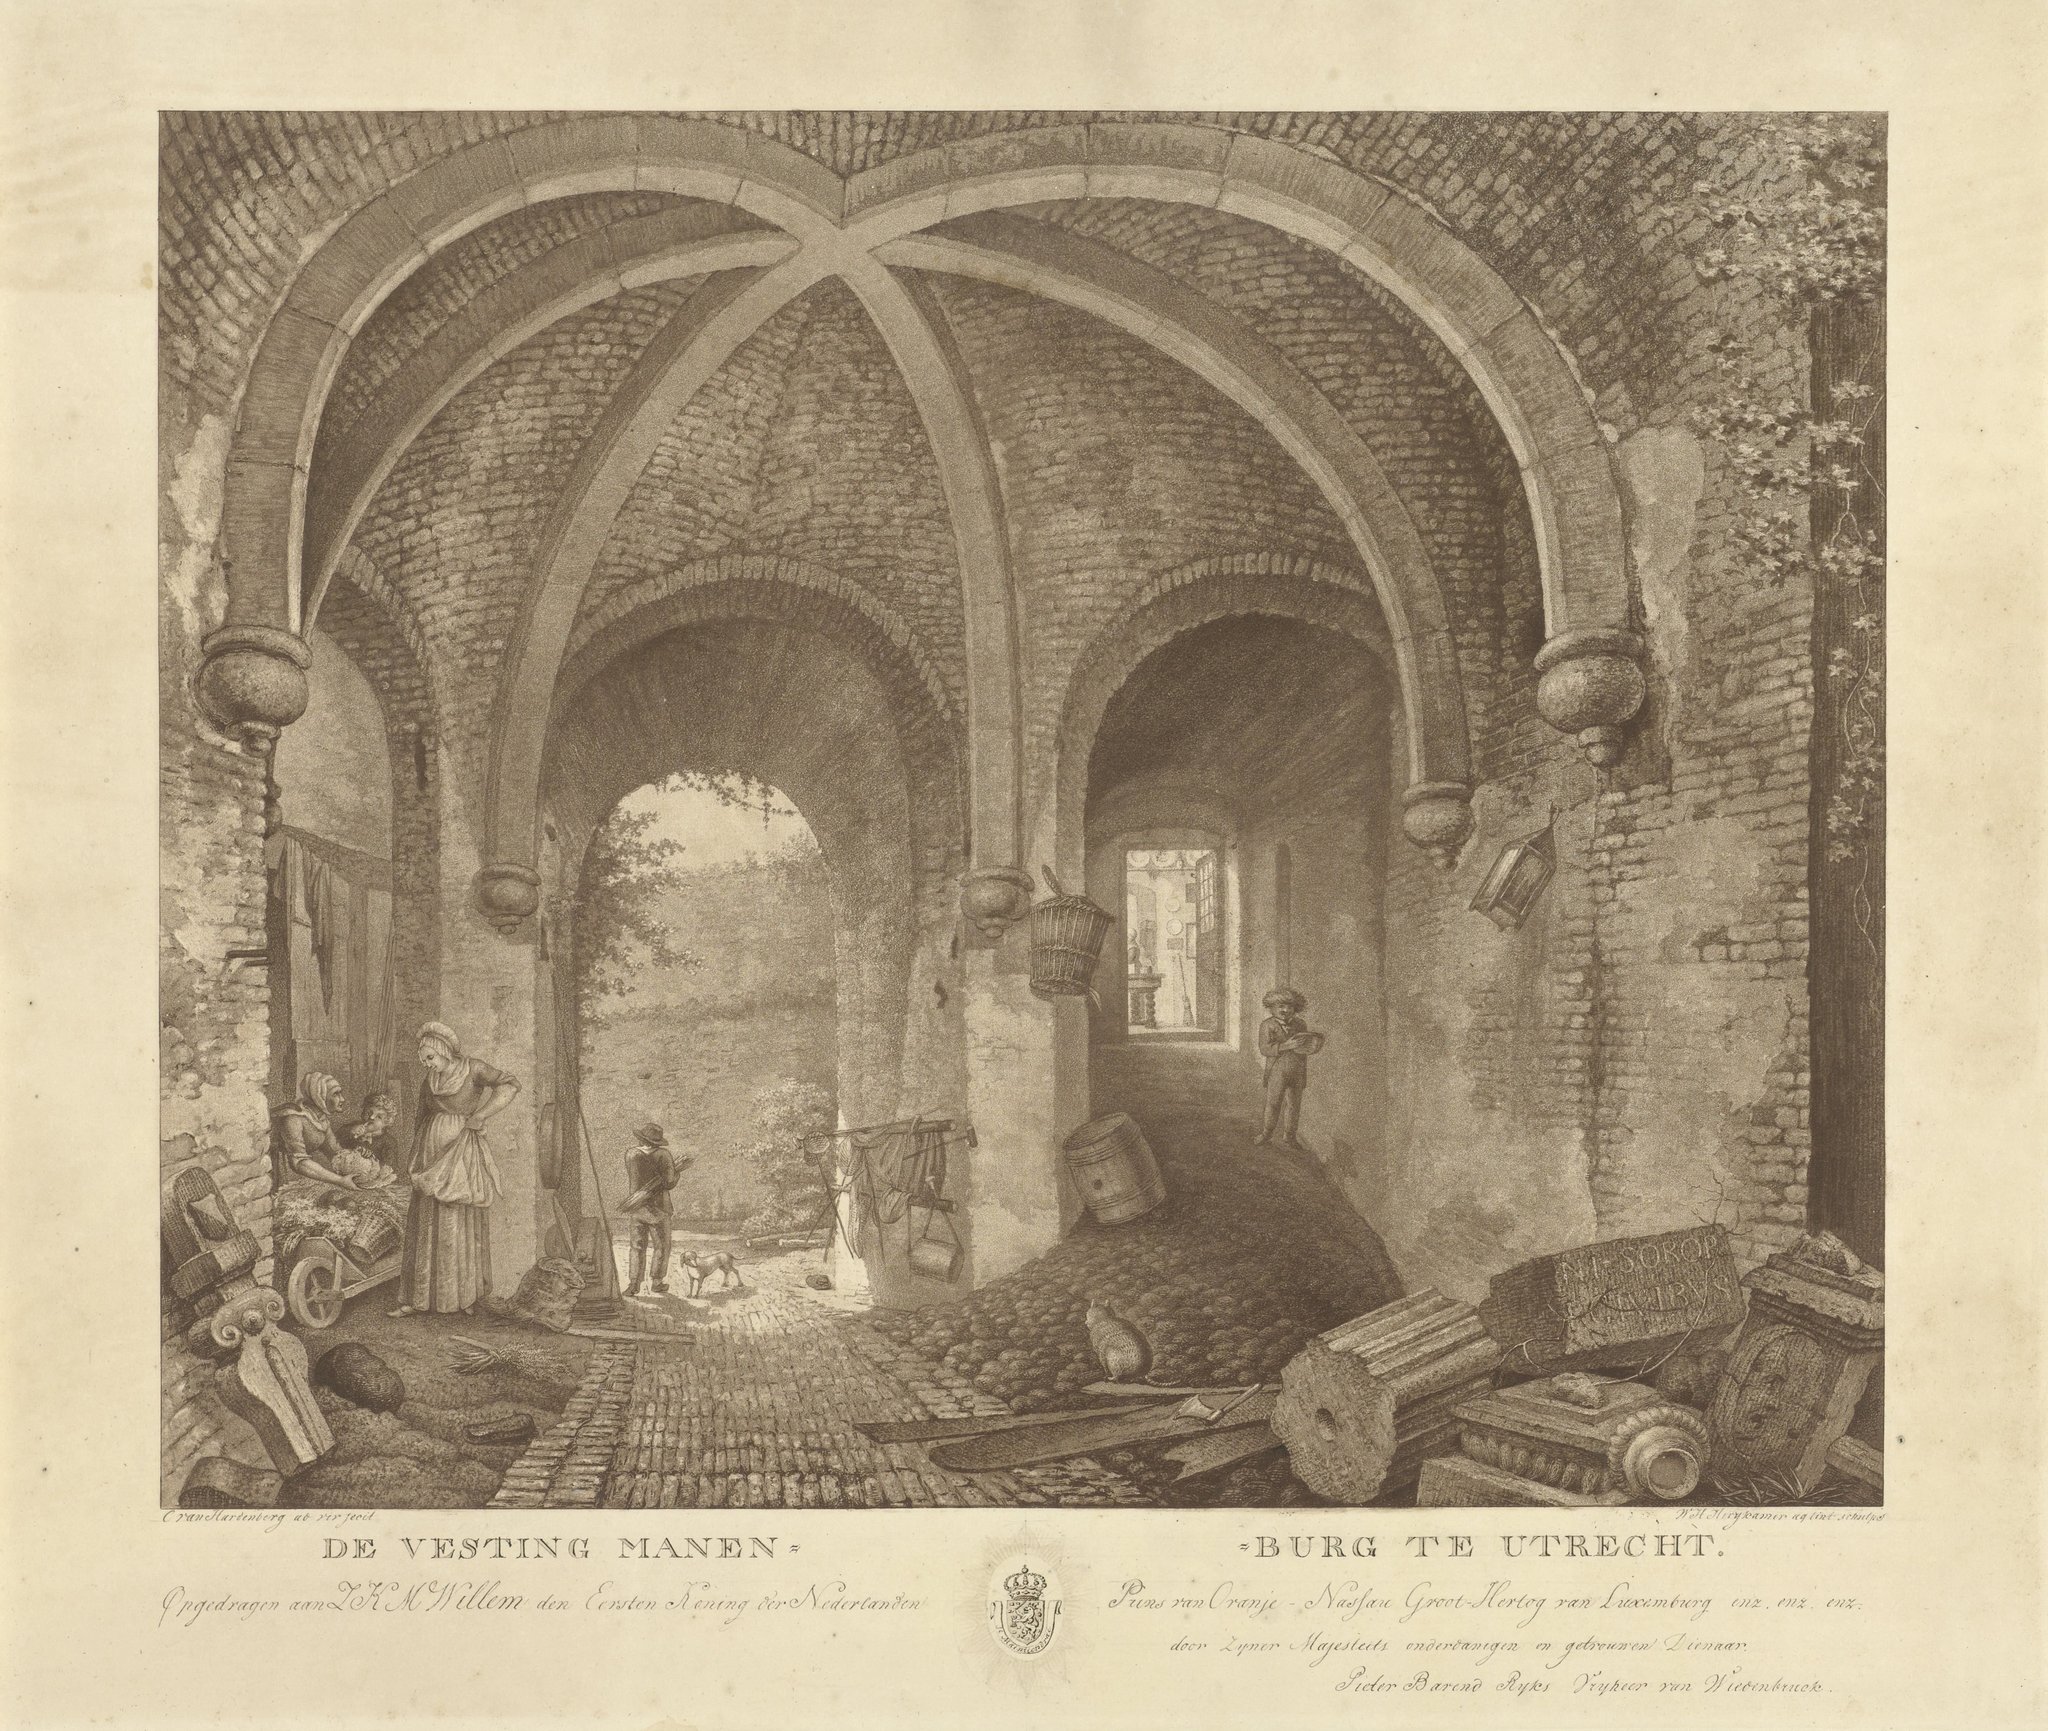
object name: print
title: De vesting Manenburg te Utrecht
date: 1816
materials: paper, pencil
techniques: aquatint, brush, pen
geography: utrecht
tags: vault ~ architecture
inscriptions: collector's mark: Lugt 2228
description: Prent maakt deel uit van de uitgave: Pieter Barend Rijksvrijheer van Wiedenbruck, Verzameling van bouw- en beeldhouwkunst, en vele verdere zeldzaamheden ..., Utrecht (W.F. Stamrood) 1816